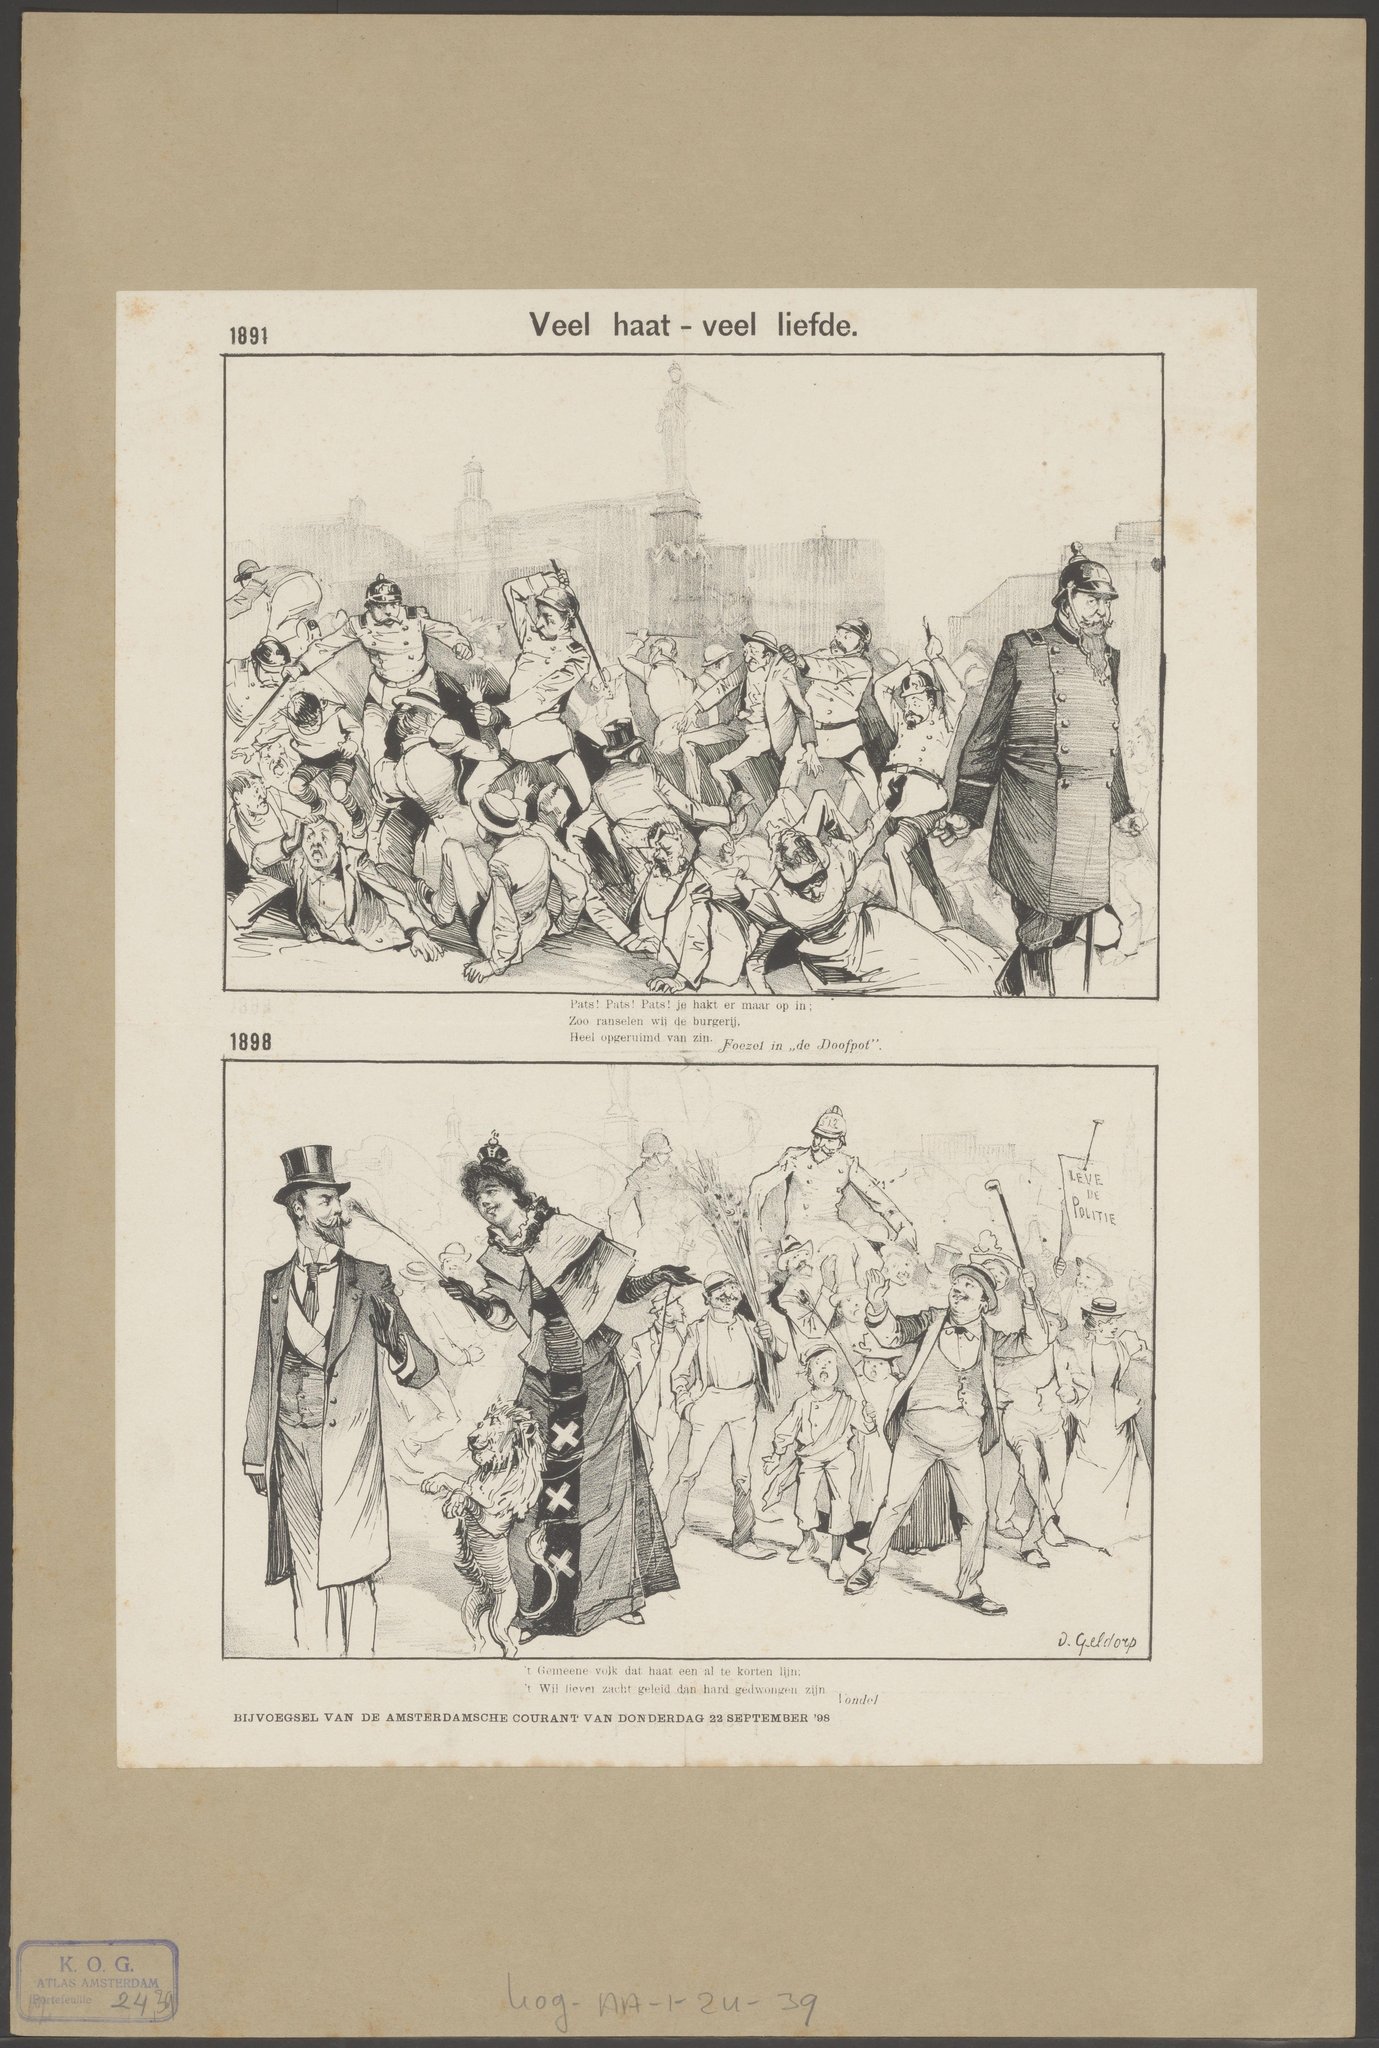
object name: cartoon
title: Contrast tussen relatie van Amsterdamse politie met burgers in 1891 en 1898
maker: petrus van geldorp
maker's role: draughtsman, print maker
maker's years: 1872-1939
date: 1898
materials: paper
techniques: letterpress printing, lithograph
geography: netherlands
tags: delft, personification of a city, town-patron(ess), beasts of prey, predatory animals: lion, fighting, police, amsterdam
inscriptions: collector's mark: Lugt 1641b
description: Gepubliceerd als bijvoegsel van 'De Amsterdamsche Courant', 22 september 1898.